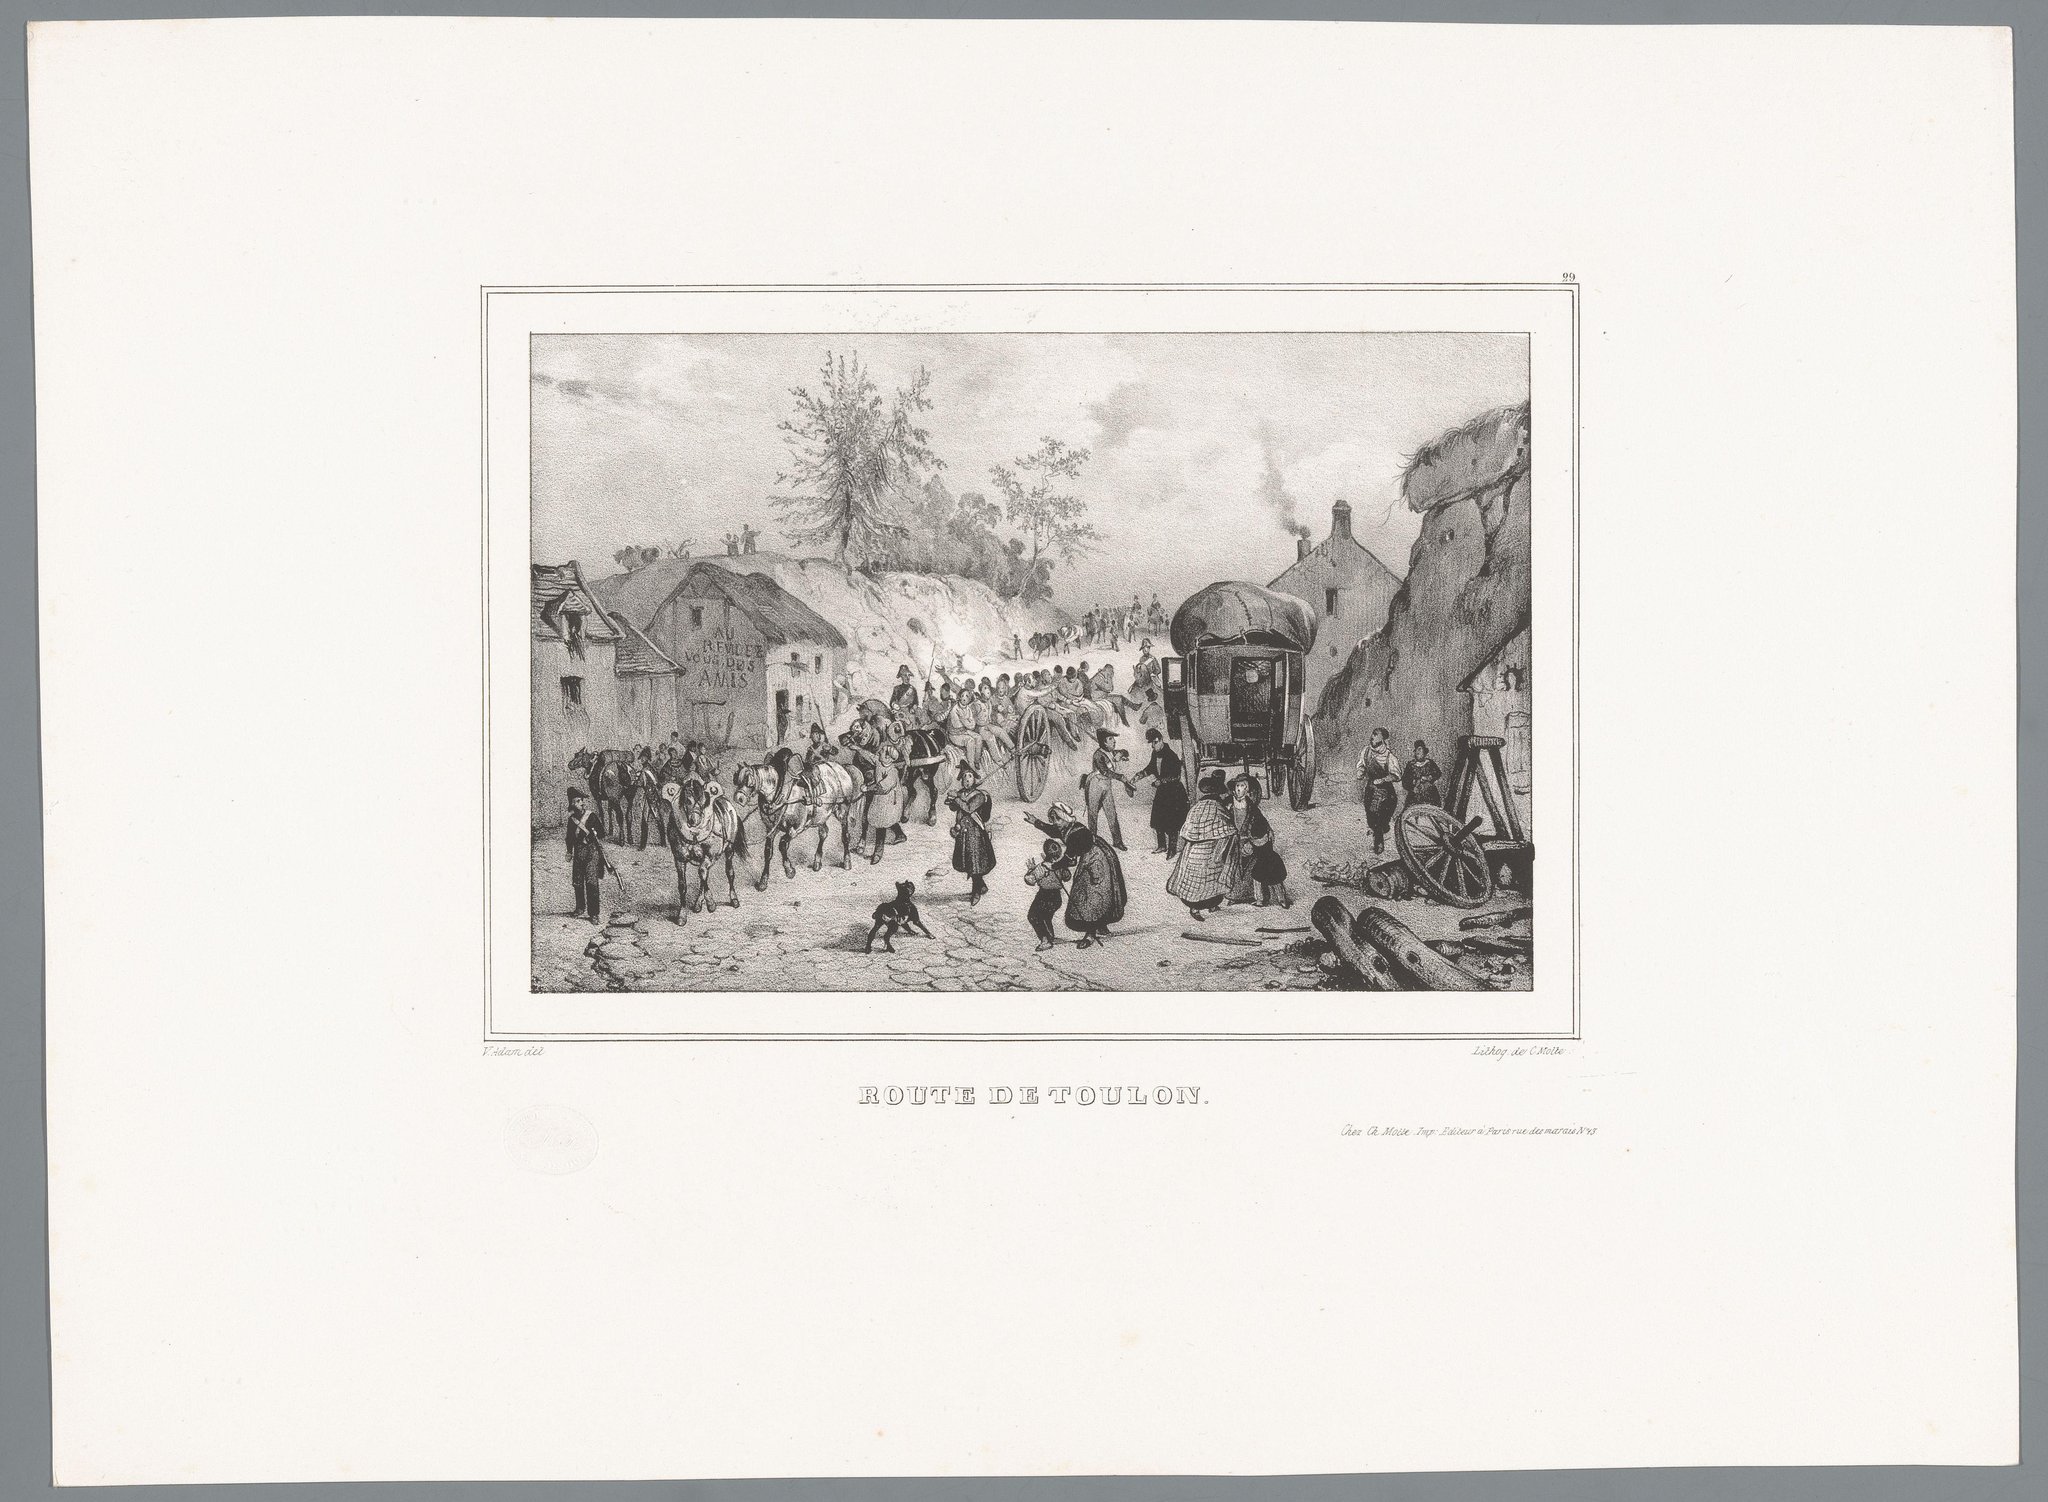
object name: print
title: Weg naar Toulon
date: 1830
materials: paper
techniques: lithography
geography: paris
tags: four-wheeled vehicle drawn by three animals, traffic and transport, 'en route', traveller under way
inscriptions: collector's mark: Lugt 2228, stamp: Lugt 1828b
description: De prentserie waar deze prent deel van uitmaakt werd in drie delen van twaalf prenten vanaf 1827 tot en met 1830 gepubliceerd. Elk van de drie delen werd voorzien van een aparte omslag.